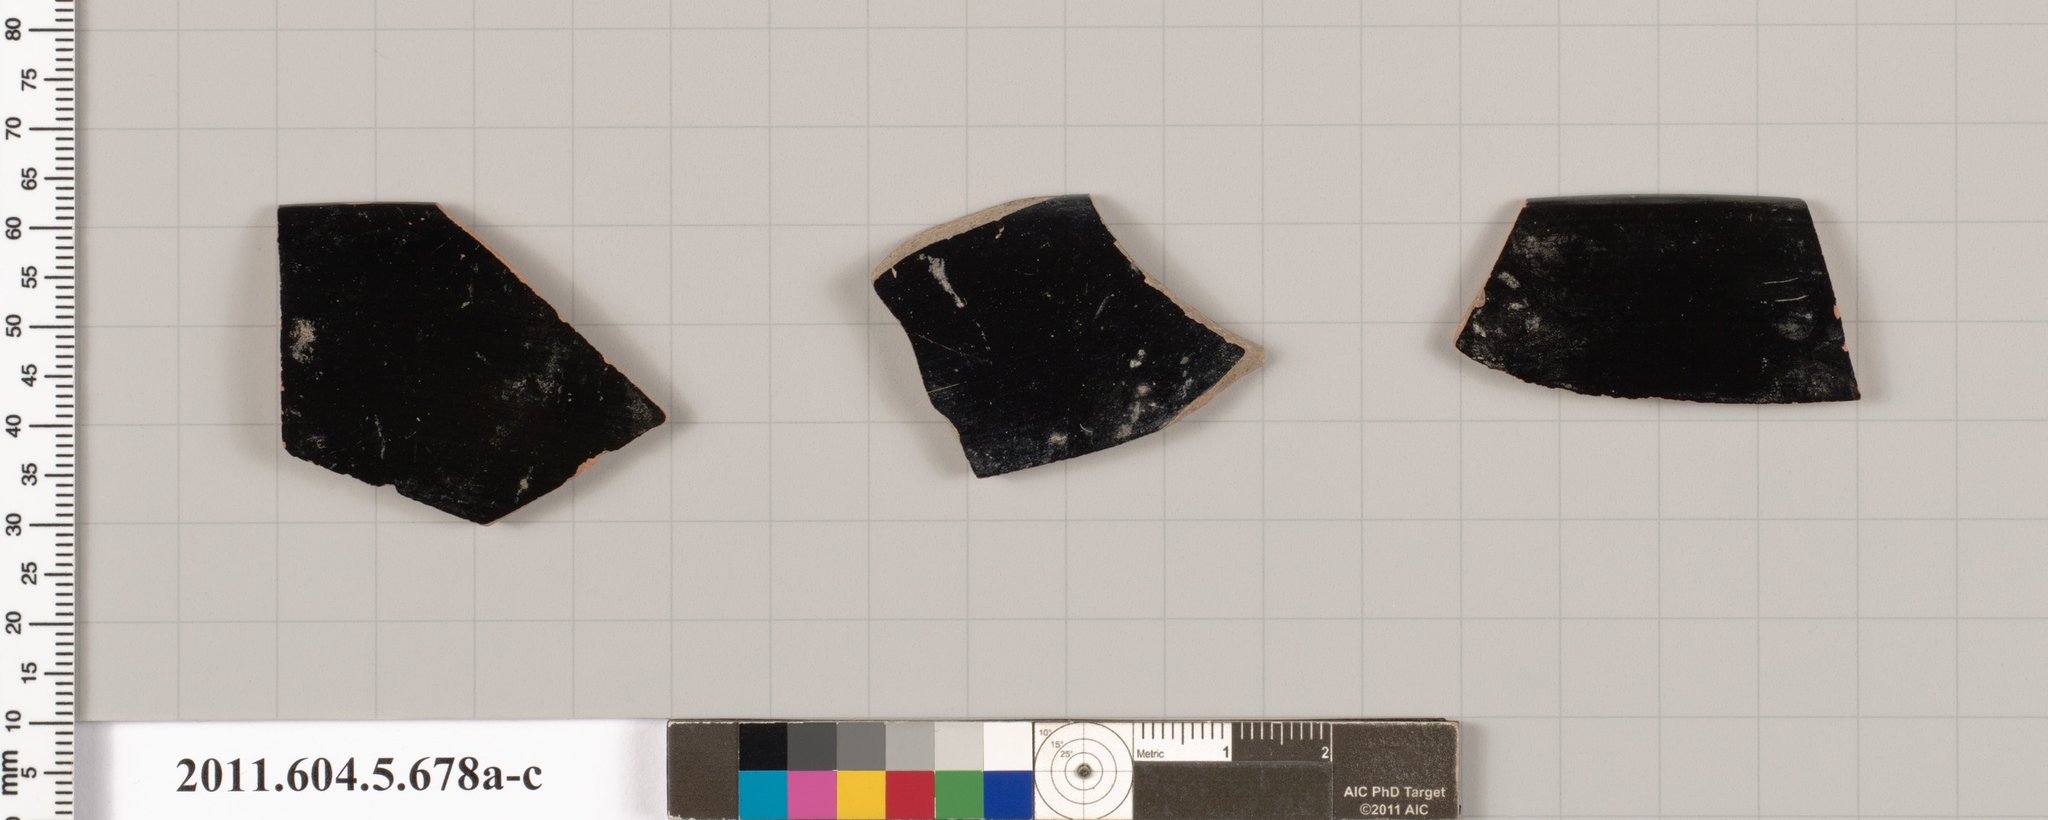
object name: kylix fragment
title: Terracotta rim fragments of kylikes (drinking cups)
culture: greek, attic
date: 600-401 BCE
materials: terracotta